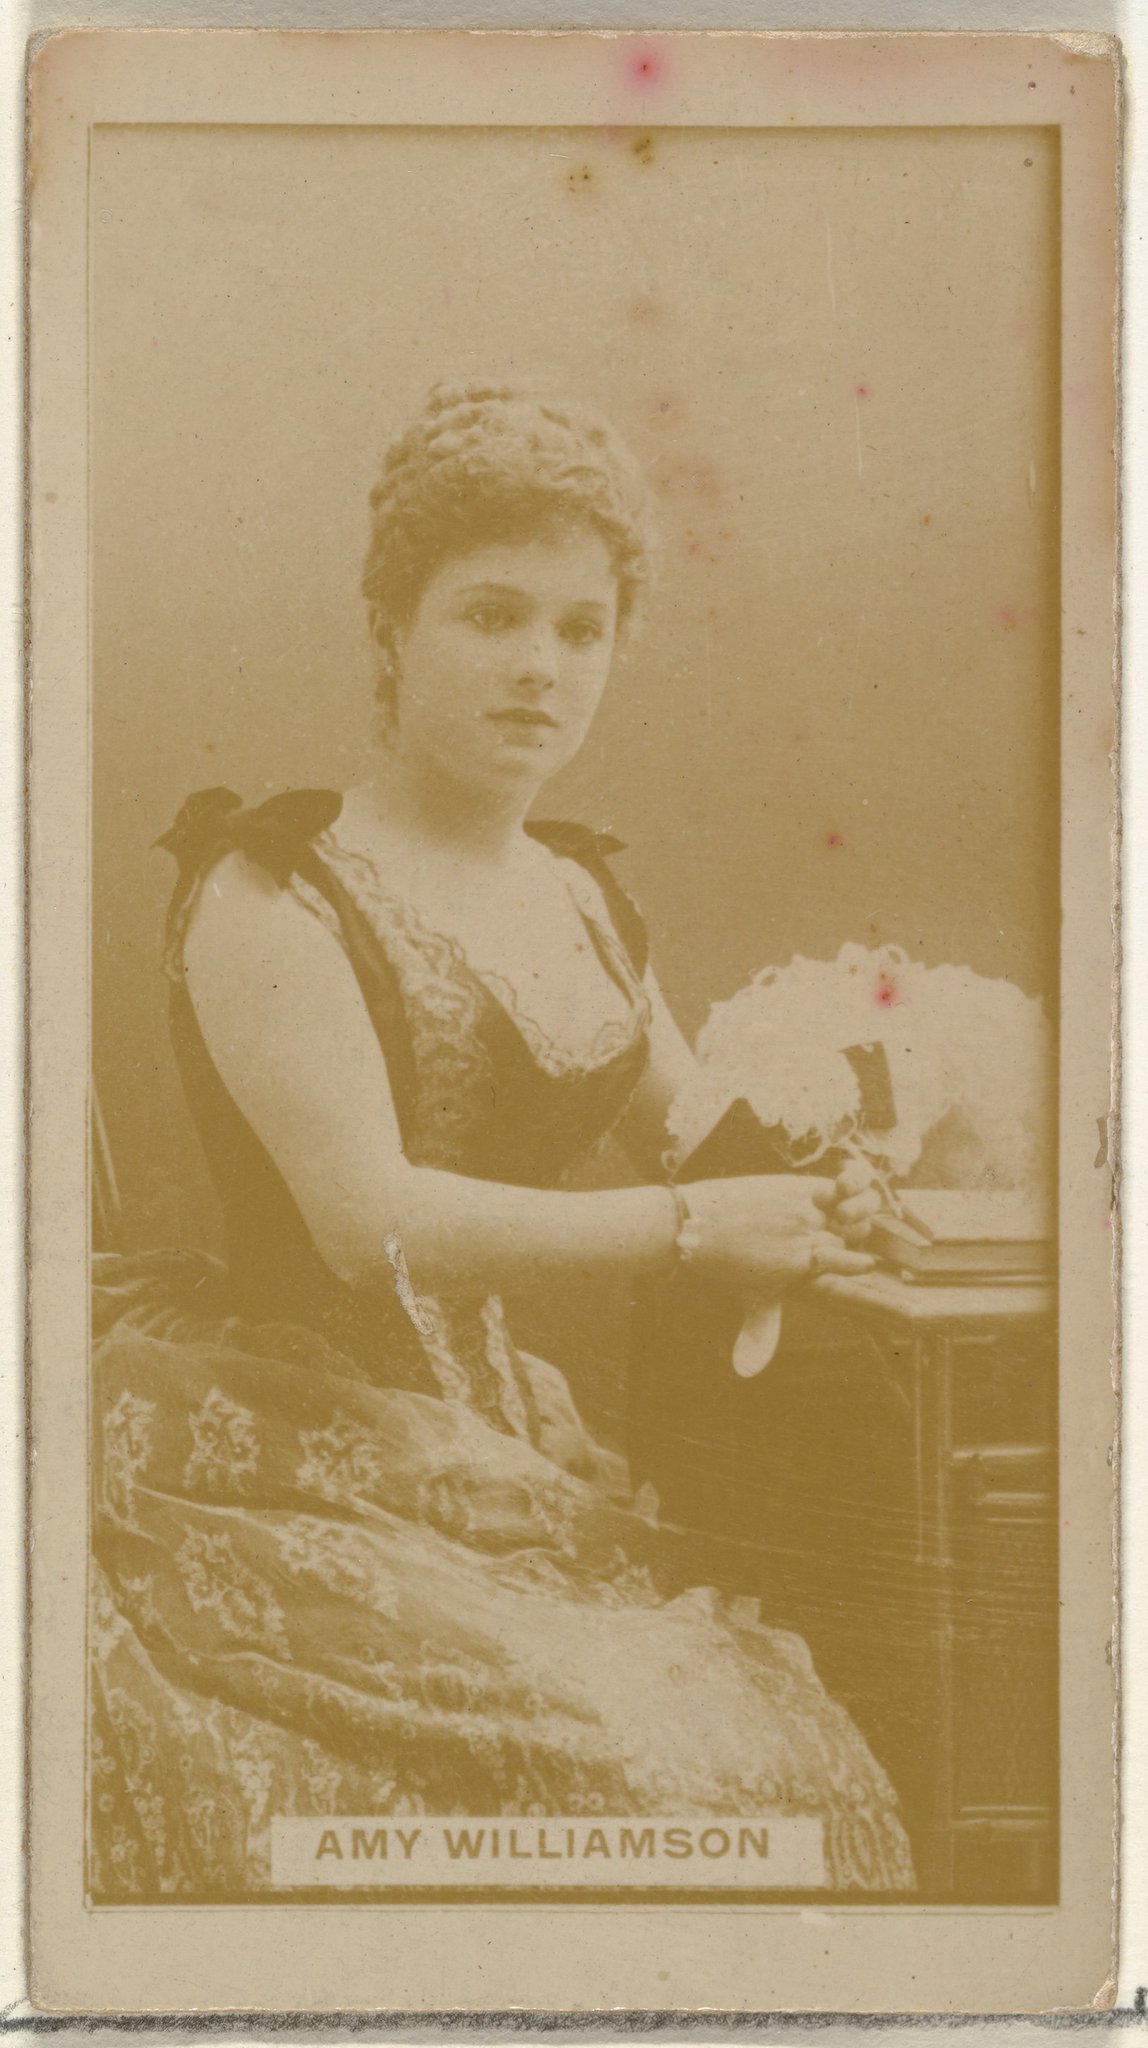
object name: photograph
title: Amy Williamson, from the Actors and Actresses series (N145-8) issued by Duke Sons & Co. to promote Duke Cigarettes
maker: w. duke, sons & co.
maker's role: publisher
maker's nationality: american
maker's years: 1870-1920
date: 1891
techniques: albumen silver print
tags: portraits,women,actresses